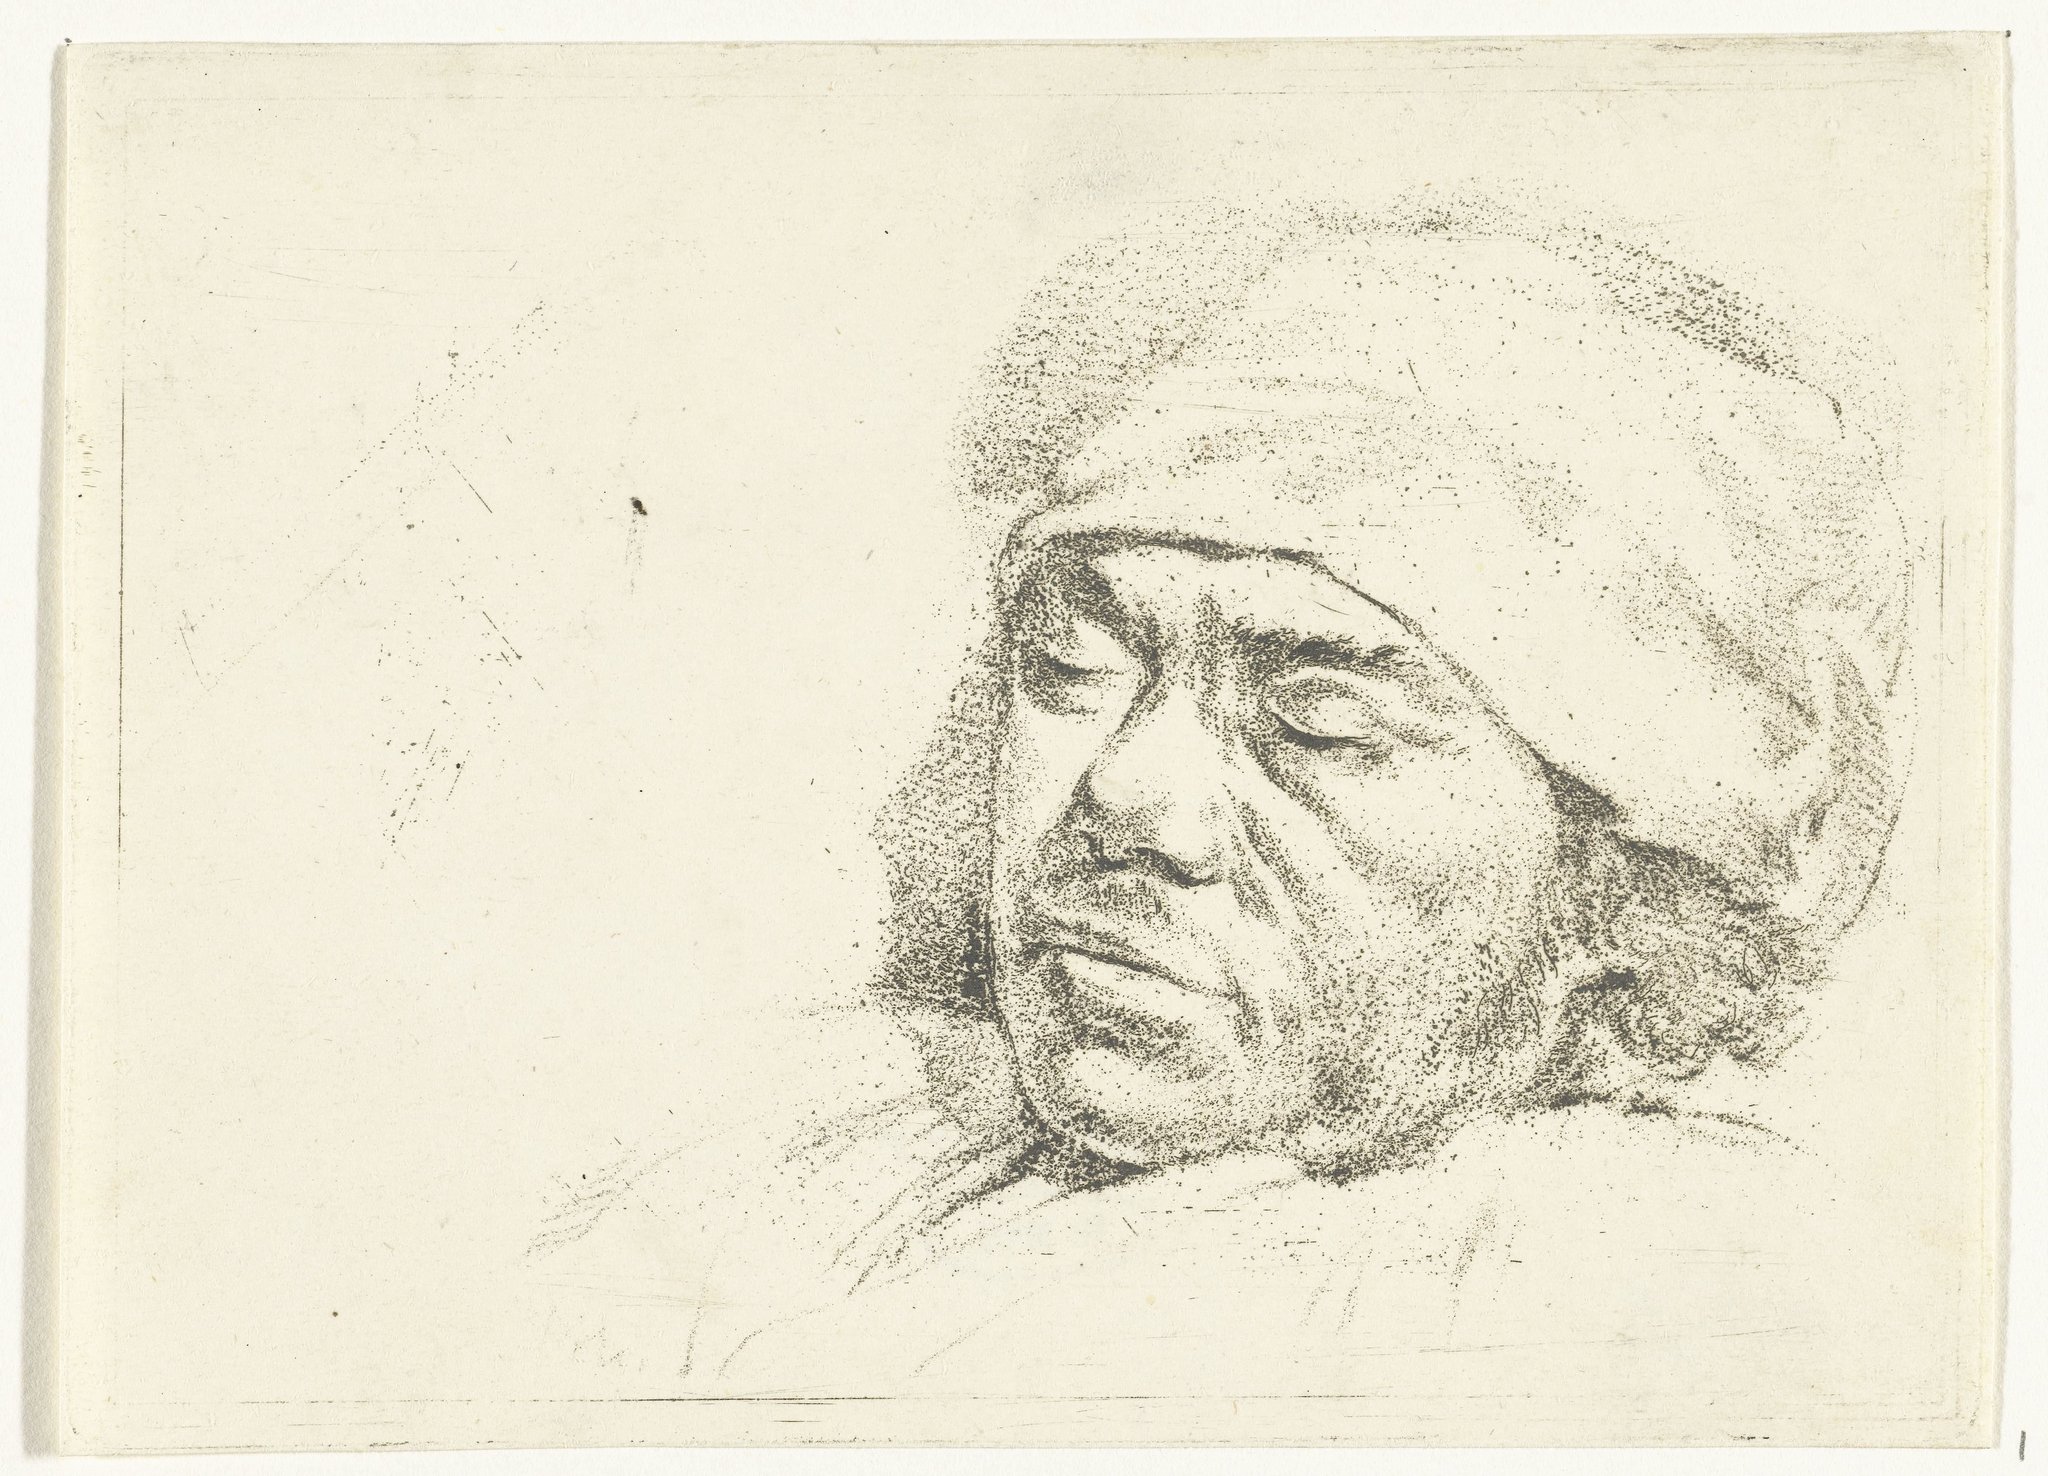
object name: print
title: Portret van de schilder Franciscus Andreas Milatz op zijn doodsbed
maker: hermanus van brussel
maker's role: draughtsman, print maker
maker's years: 1763-1815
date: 1808-1810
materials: paper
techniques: soft ground etching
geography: netherlands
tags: painter, franciscus andreas milatz, artist on his deathbed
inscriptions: collector's mark: Lugt 2228